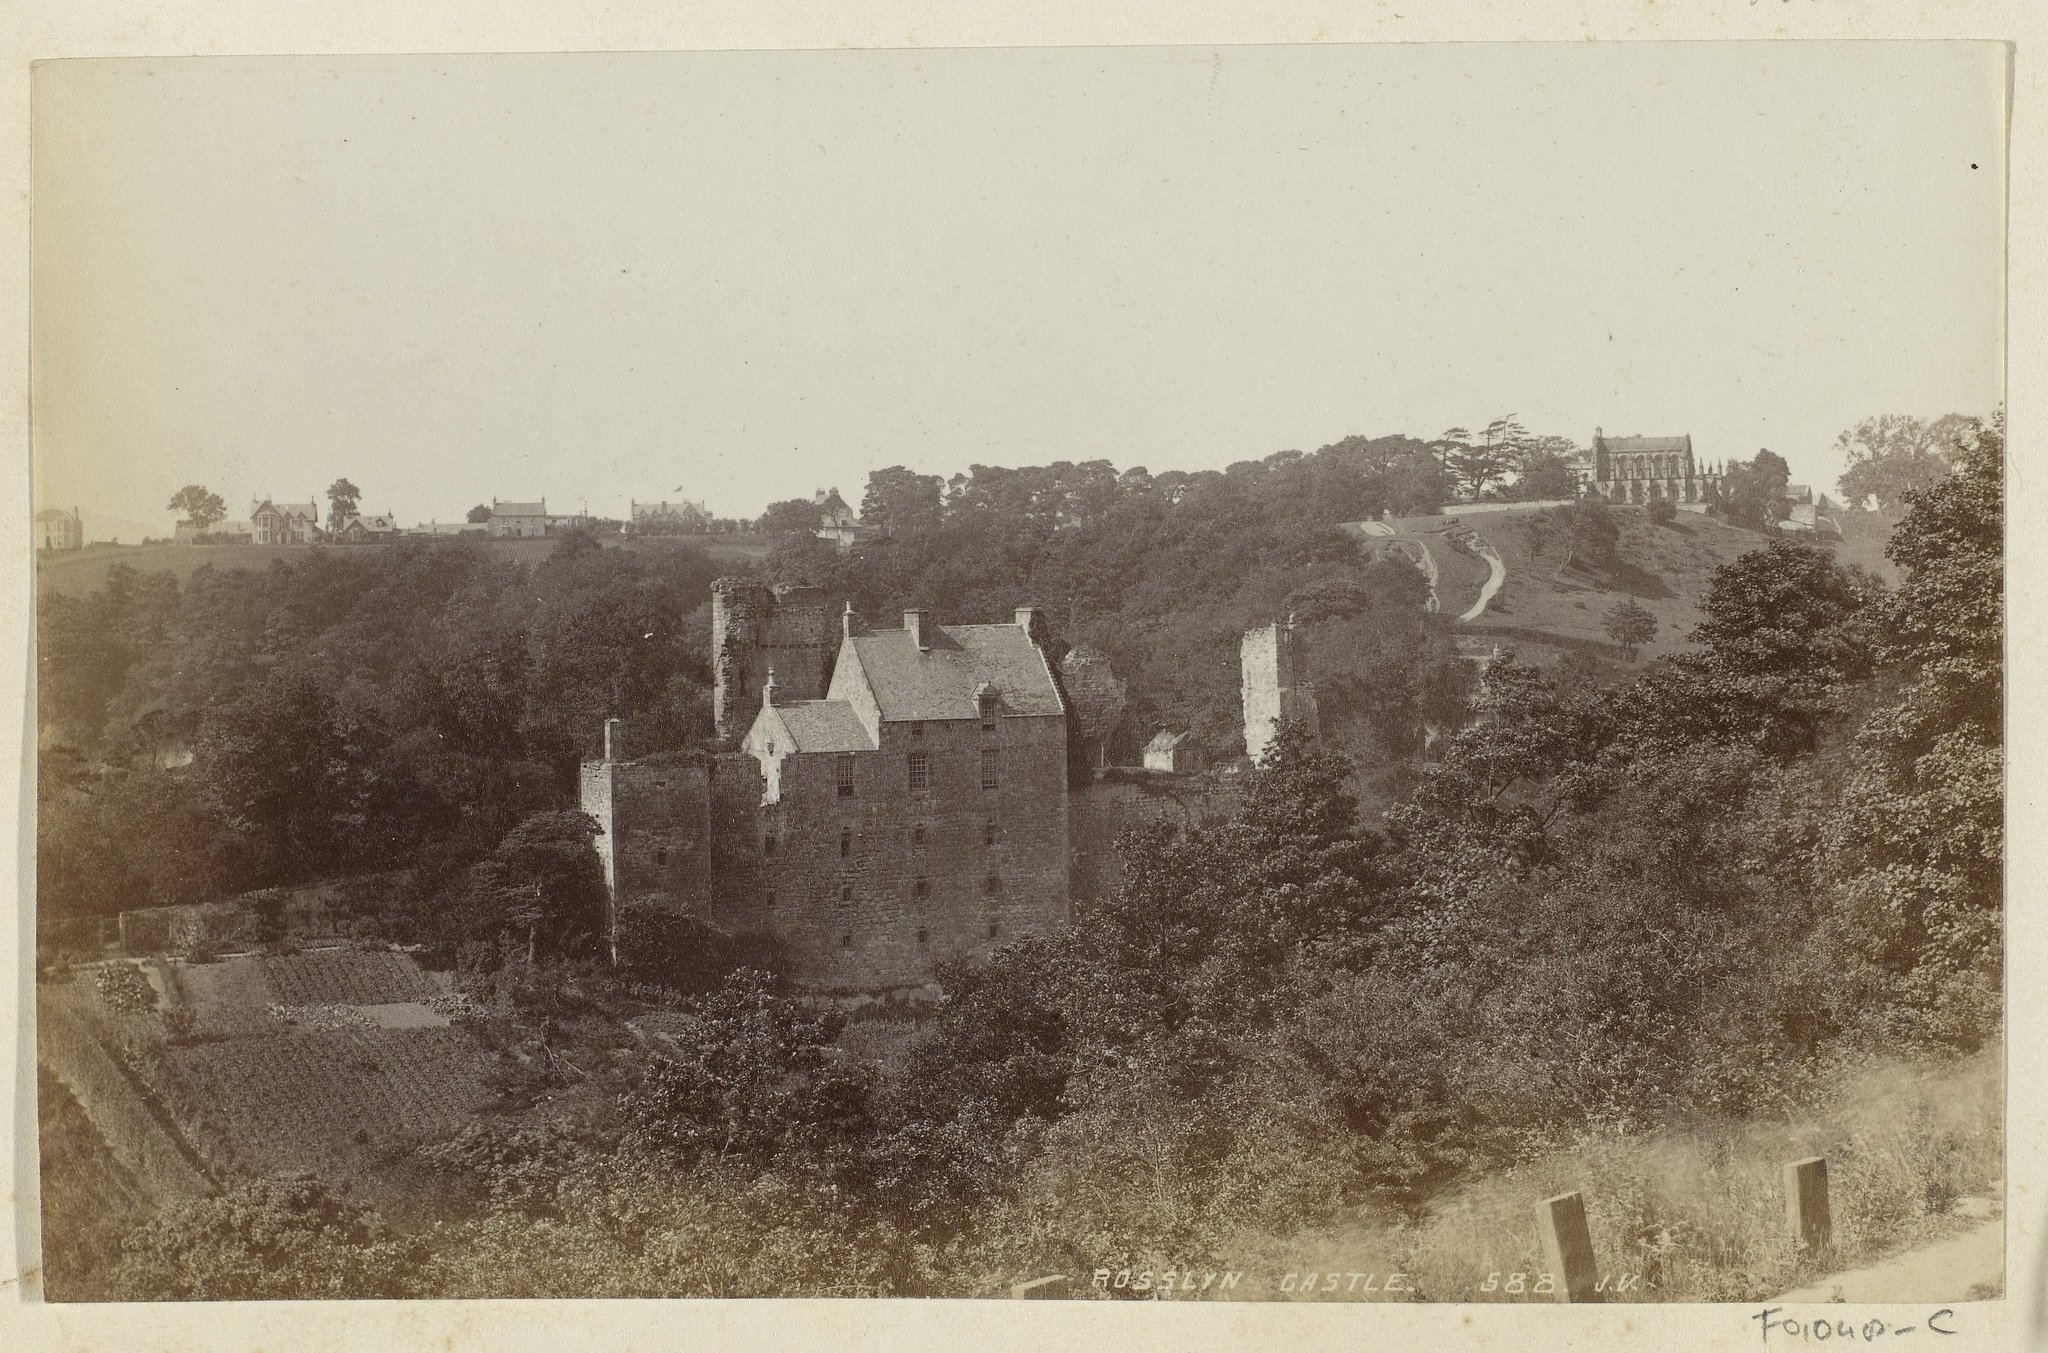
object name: photograph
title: Rosslyn Castle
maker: james valentine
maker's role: fotograaf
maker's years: 1815-1880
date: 1870-1886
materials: paper, photographic support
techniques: albumen print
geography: roslin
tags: castle, ruin of a dwelling, house, castle, etc.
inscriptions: negative number: ‘588’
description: Onderdeel van Reisalbum van H. Dunlop met foto's van bezienswaardigheden in Perzië, Schotland, Duitsland, Rusland, China en Canada.